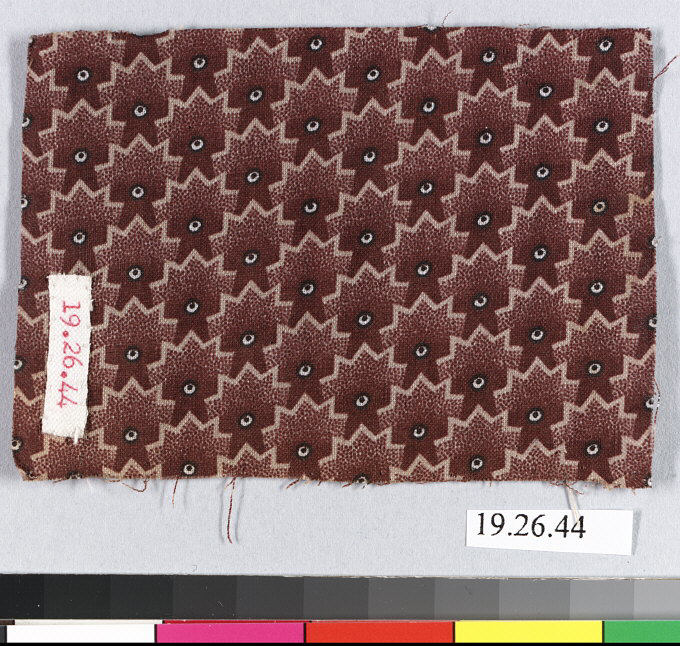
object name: sample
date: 1840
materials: cotton